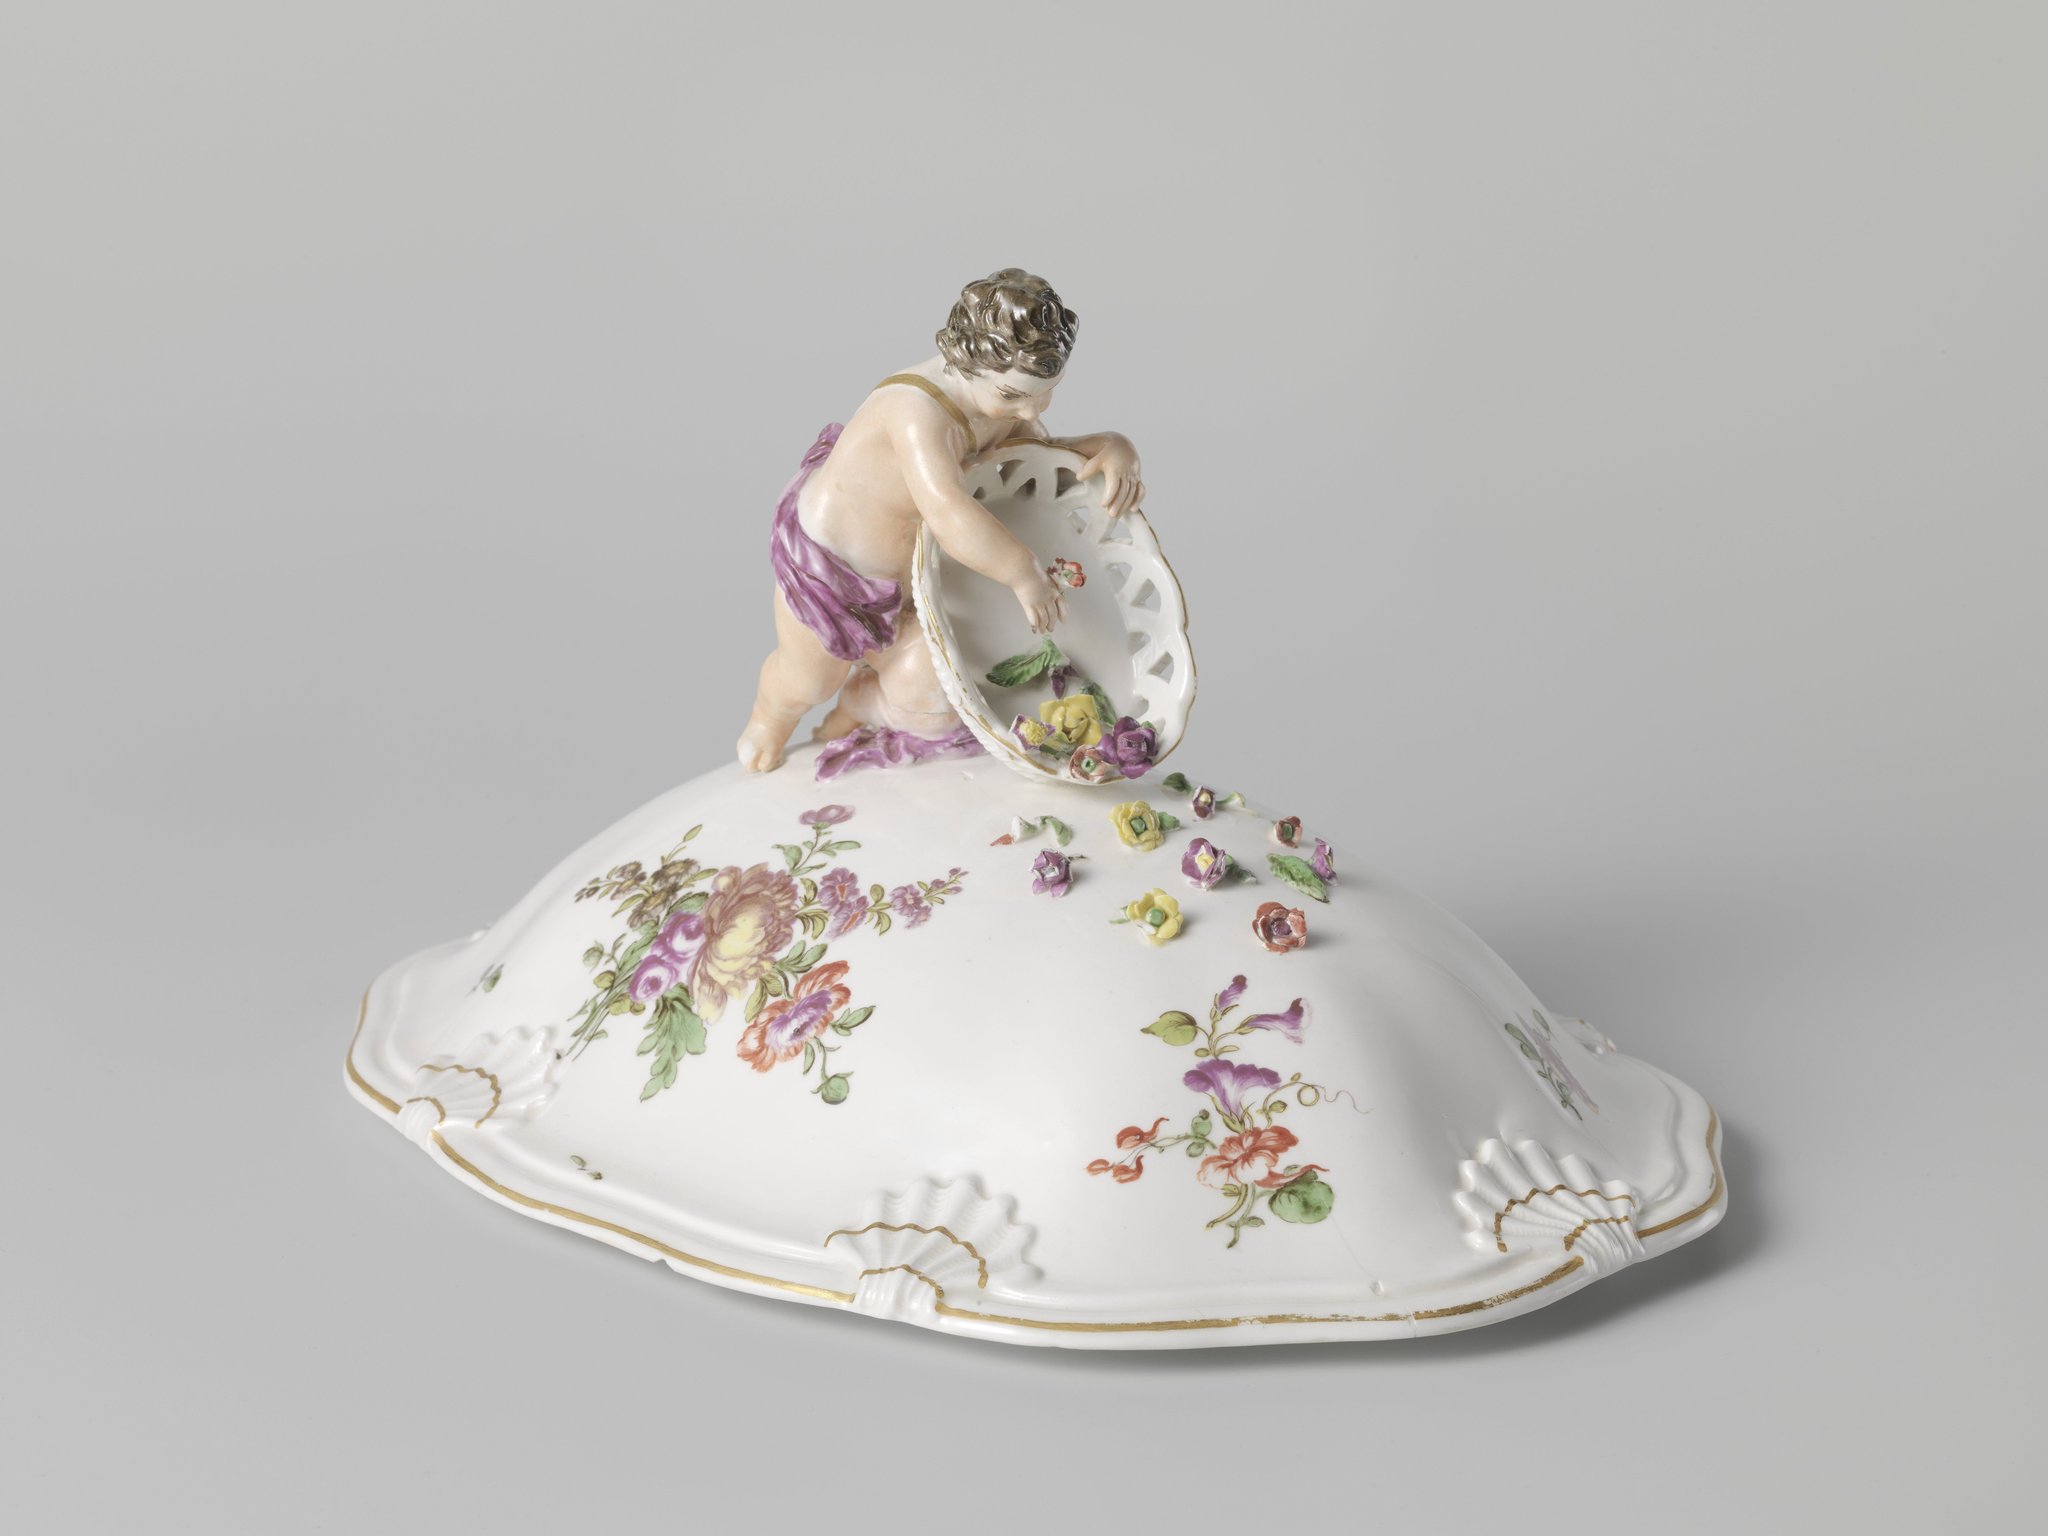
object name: lid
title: Tureen and stand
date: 1764-1768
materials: porcelain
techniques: kiln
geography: weesp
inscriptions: mark: ‘Z I’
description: The shell motifs on the handles and feet, as well as the little boy on the lid of this tureen, derive directly from a model that had been developed at the Meissen porcelain factory in the 1730s. Modeller Christiaan Gottlob Berger, who had trained in Meissen, brought the model with him to Weesp in 1759, when he was hired there.